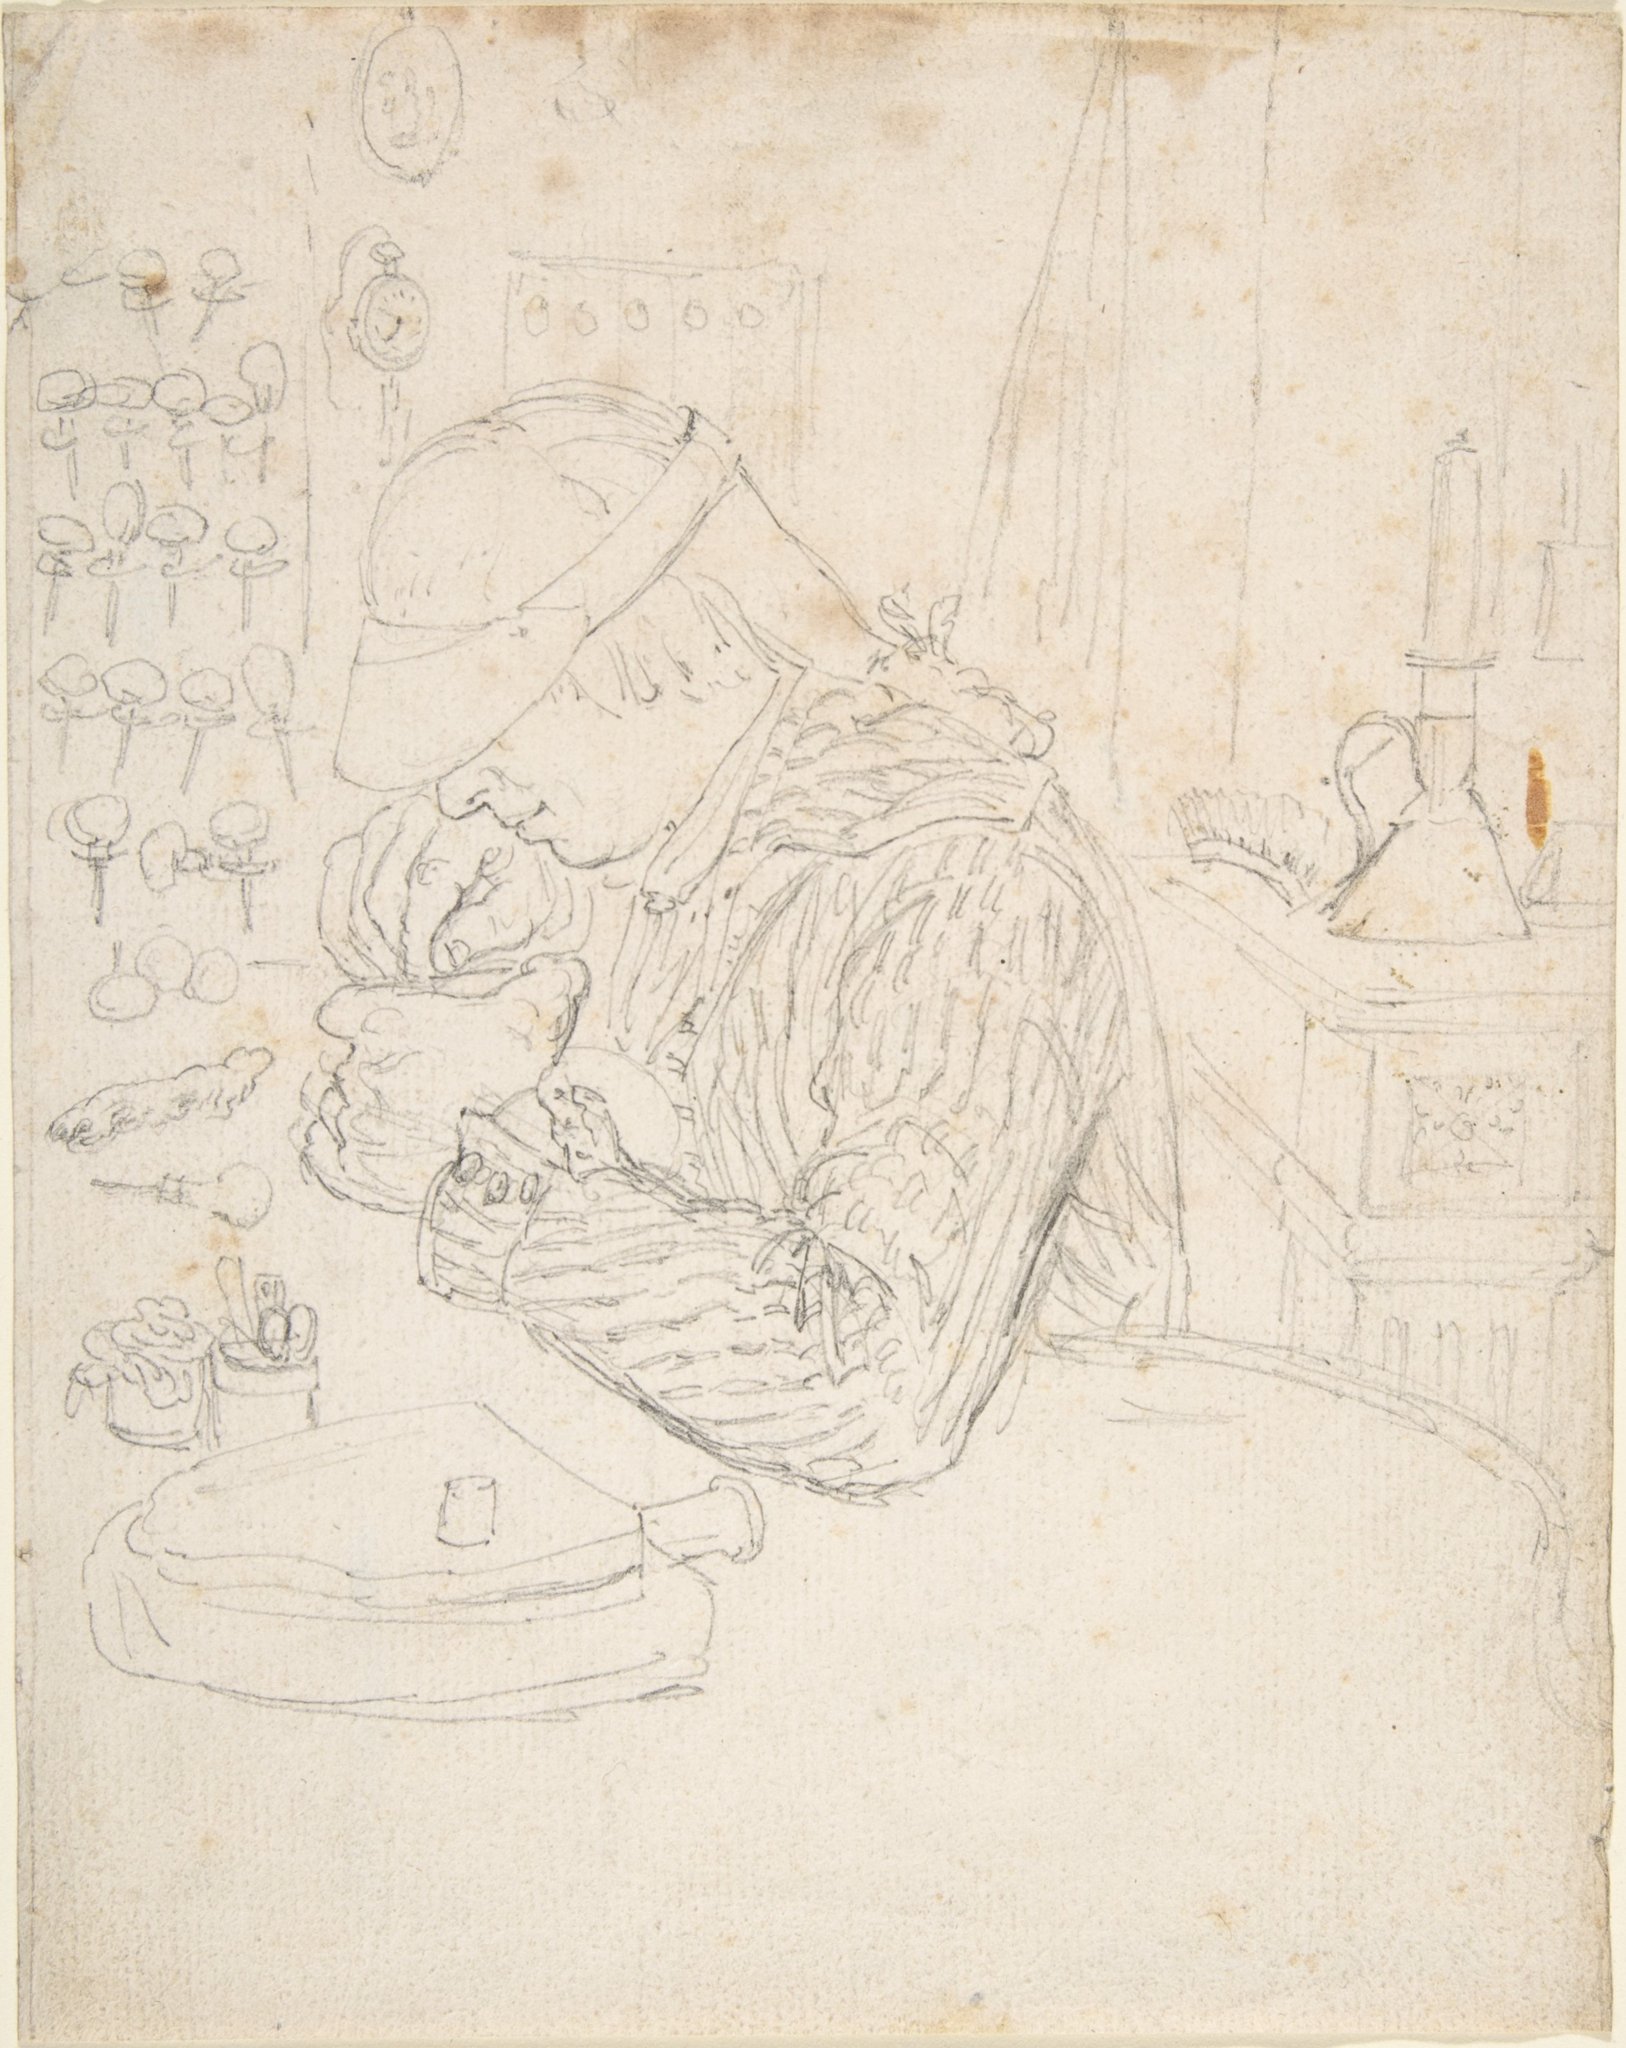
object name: drawing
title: An Engraver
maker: edouard jeanmaire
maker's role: artist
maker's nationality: french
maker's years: 1847-1916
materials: graphite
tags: men,working